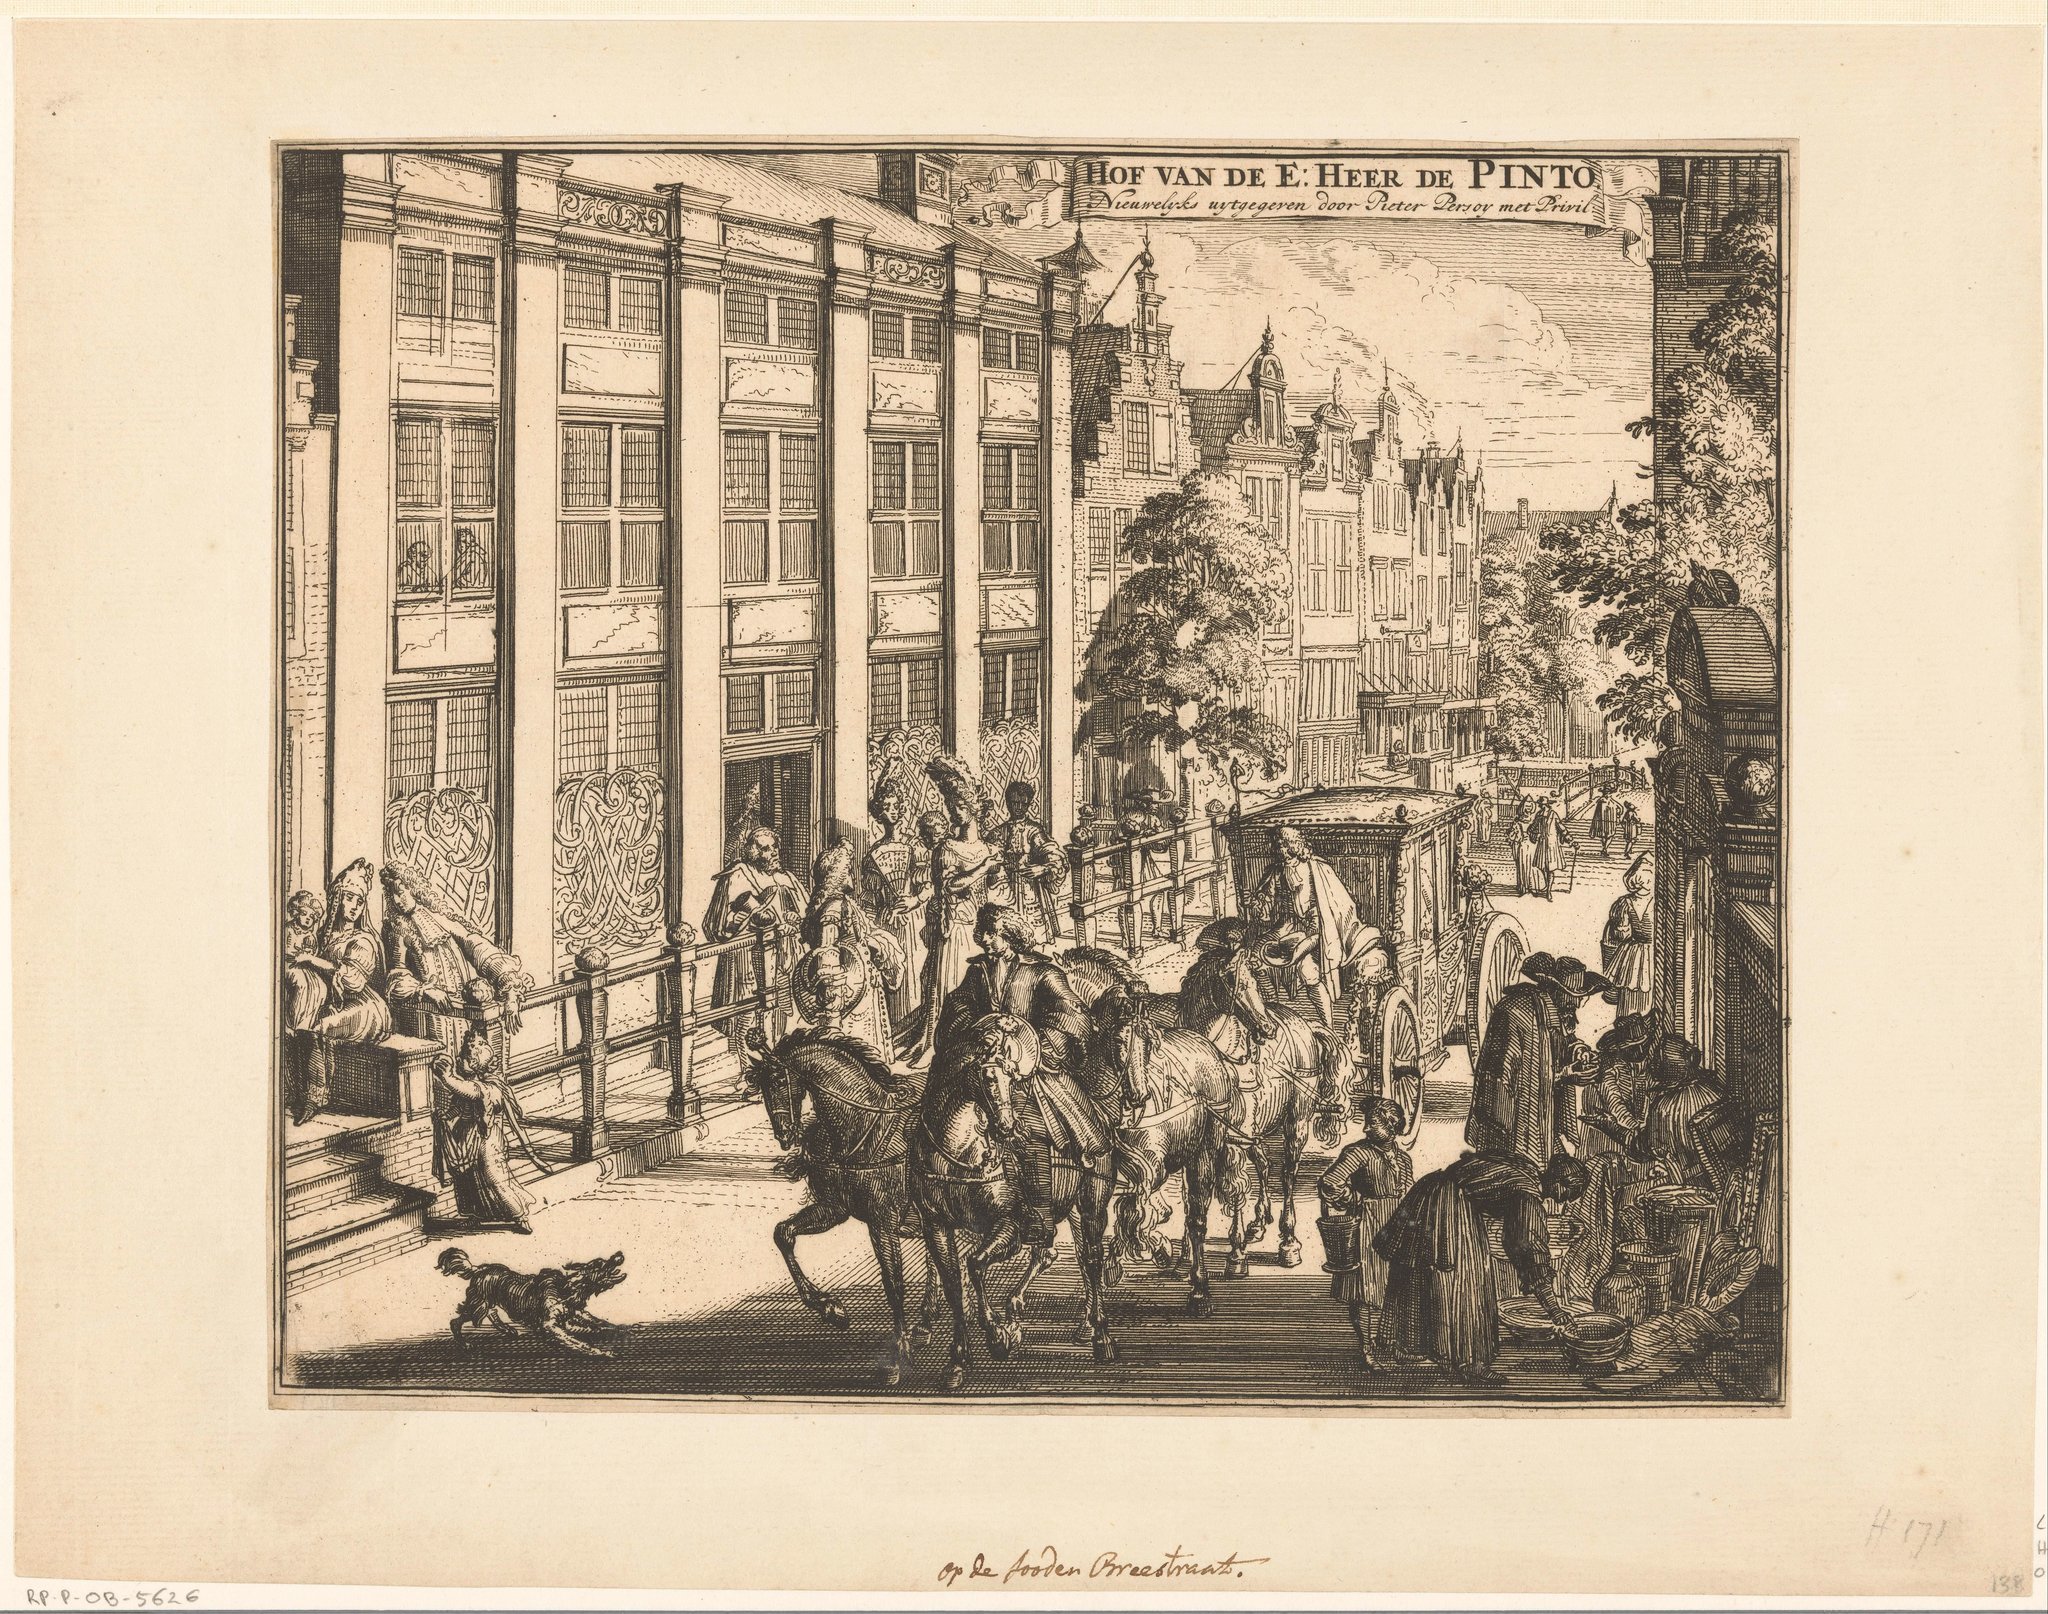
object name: print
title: Huis van David de Pinto aan de Sint-Antoniesbreestraat te Amsterdam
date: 1695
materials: paper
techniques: engraving, etching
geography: amsterdam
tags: shop, store, urban housing, 'sephardim' ~ jewish communities, four-wheeled vehicle drawn by more than three animals, street (+ city(-scape) with figures, staffage)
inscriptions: collector's mark: Lugt 2228, inscription: ‘Op de Jooden Breestraat’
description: Gezicht op het huis van David de Pinto aan de Sint-Antoniesbreestraat te Amsterdam (Huis De Pinto). Voor het gebouw staan enkele voornaam geklede dames en heren en een zwarte bediende. De man achter het hek is mogelijk David de Pinto zelf. Op straat verschillende figuren en een koets met vier paarden. Op de voorgrond rechts een verkoper van potten en pannen. Rechtsboven een banderol met de titel.